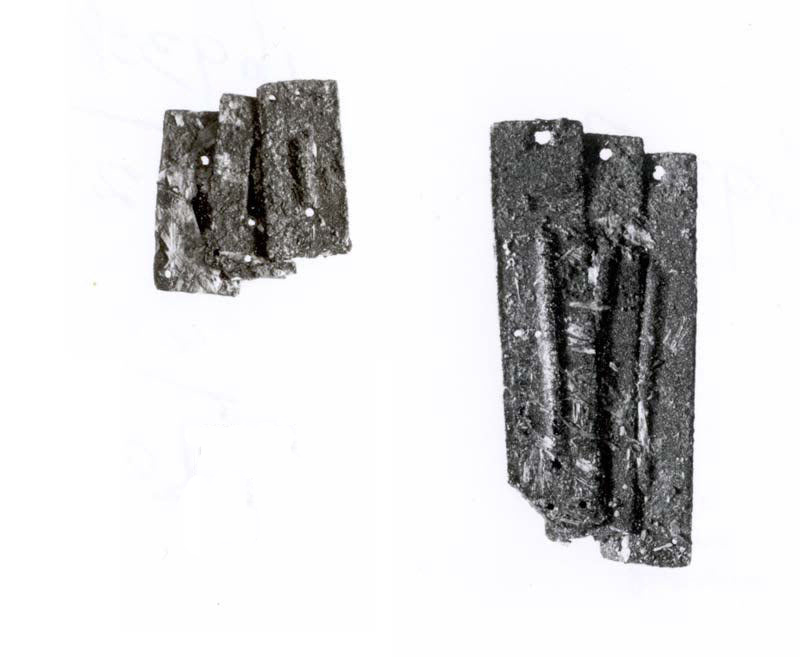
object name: armor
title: Armor plates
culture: assyrian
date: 734-601 BCE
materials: bronze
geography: mesopotamia